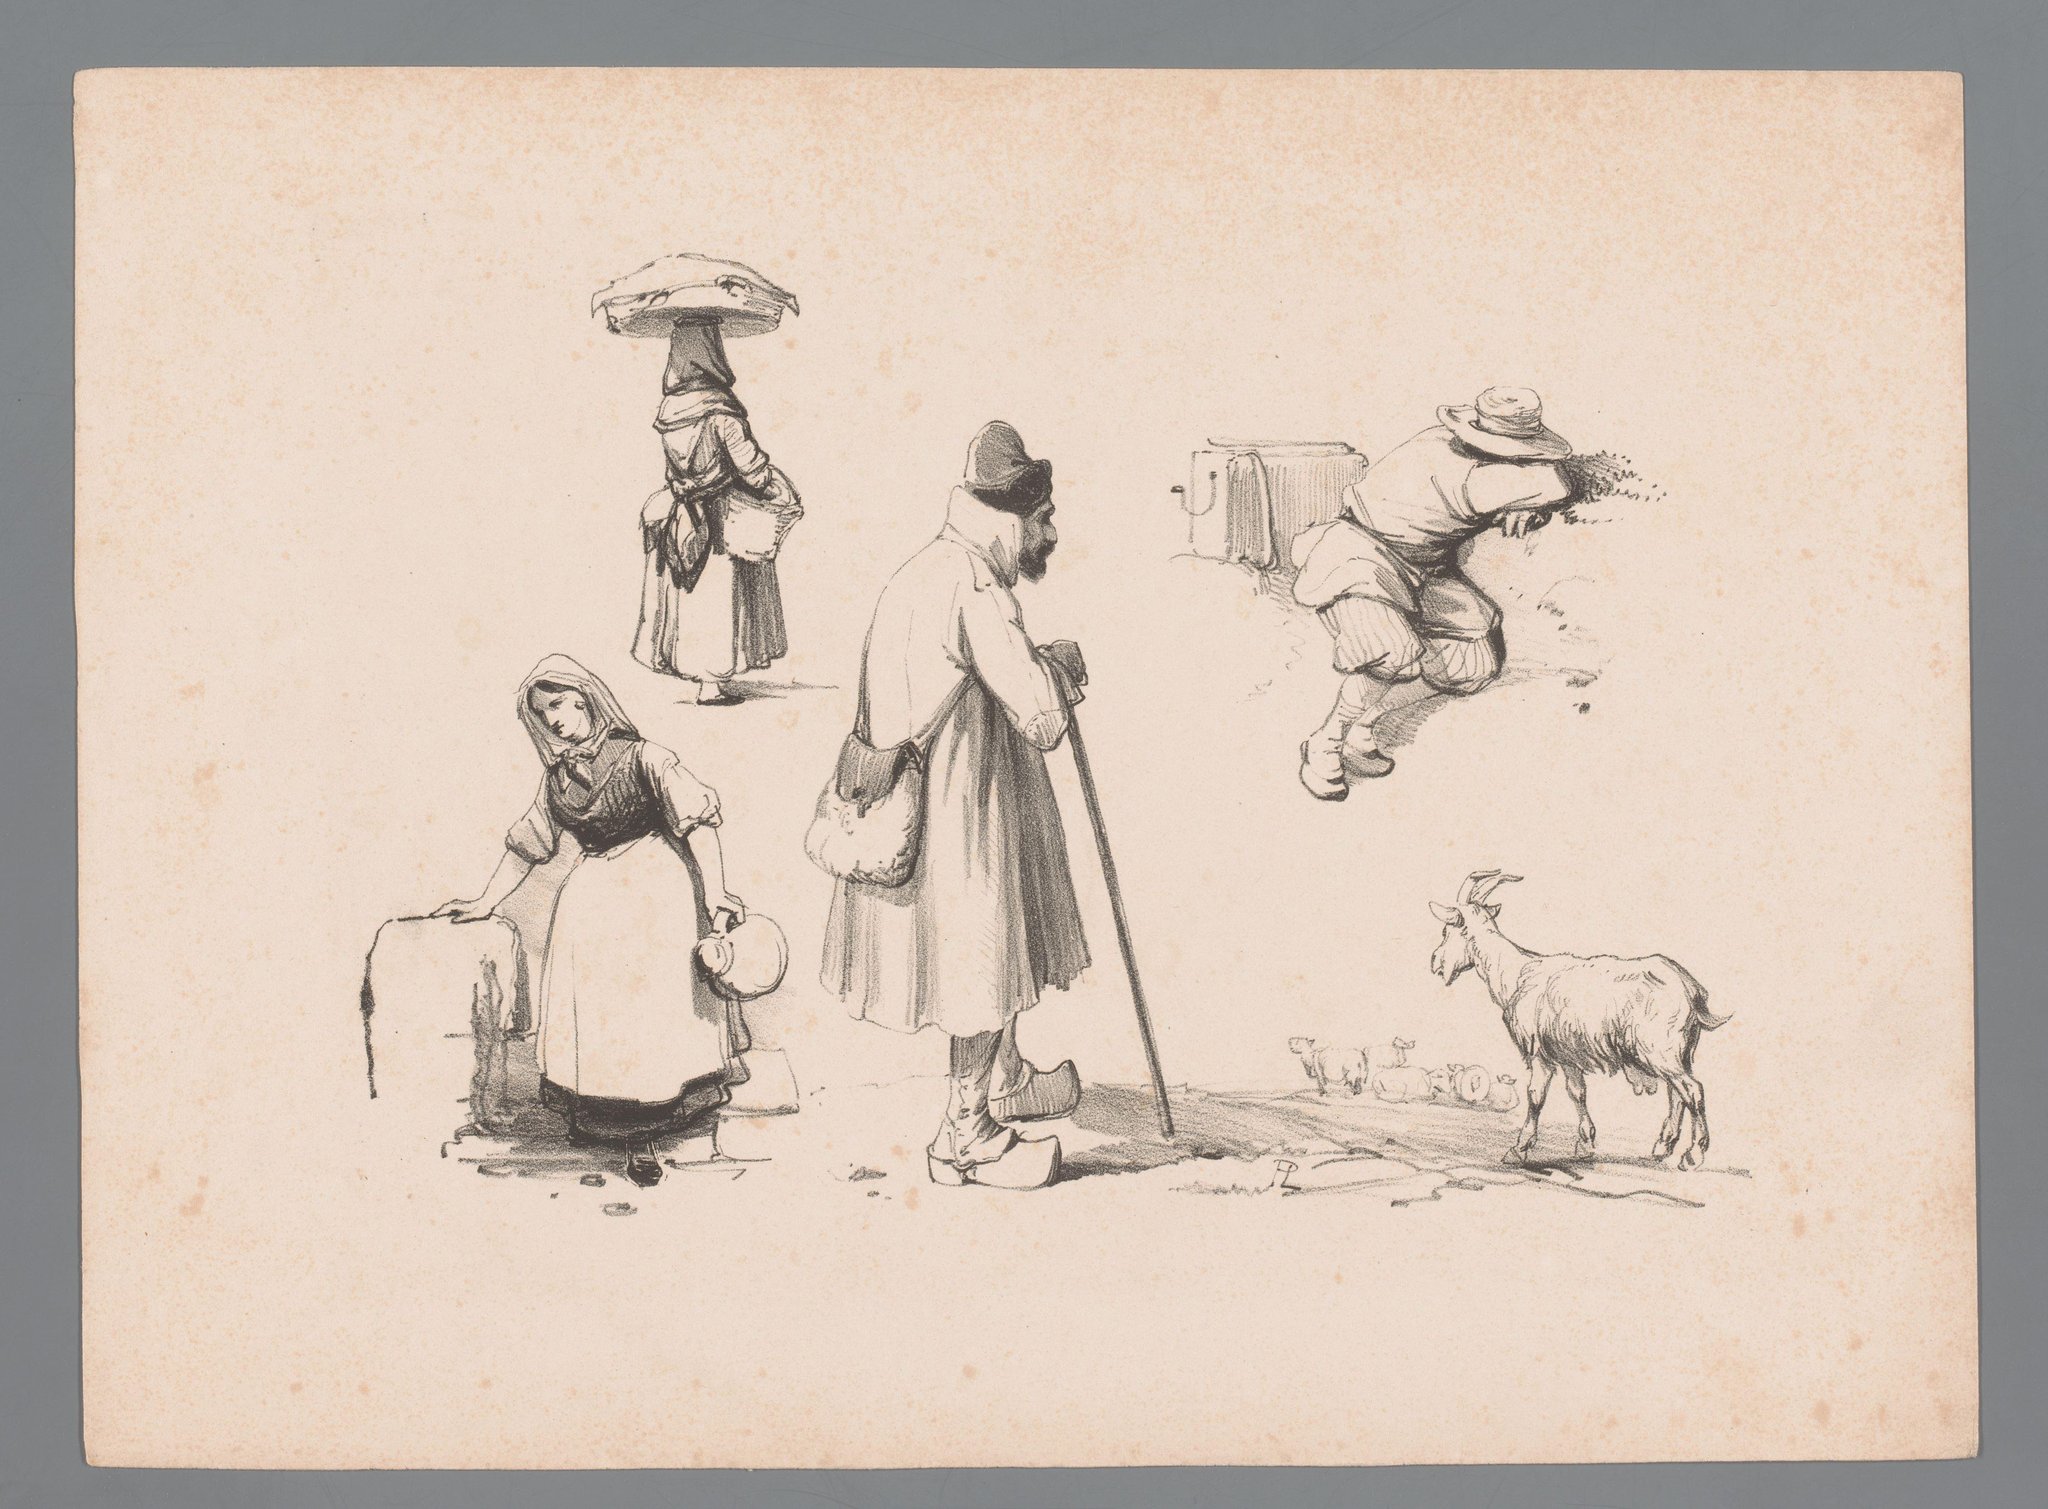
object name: print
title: Figuurstudies van een geitenhoeder, een vrouw met kruik, een vrouw met mand op haar hoofd en een slapende man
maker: paulus lauters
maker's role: print maker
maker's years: 1806-1875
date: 1816-1875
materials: paper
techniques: lithograph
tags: adult woman, sleeping; unconsciousness - bb - out of doors, herding, herdsman, herdswoman, shepherd, shepherdess, cowherd, etc., jar, jug (used as drinking-vessel), goat, carrying something on the head or on the shoulders